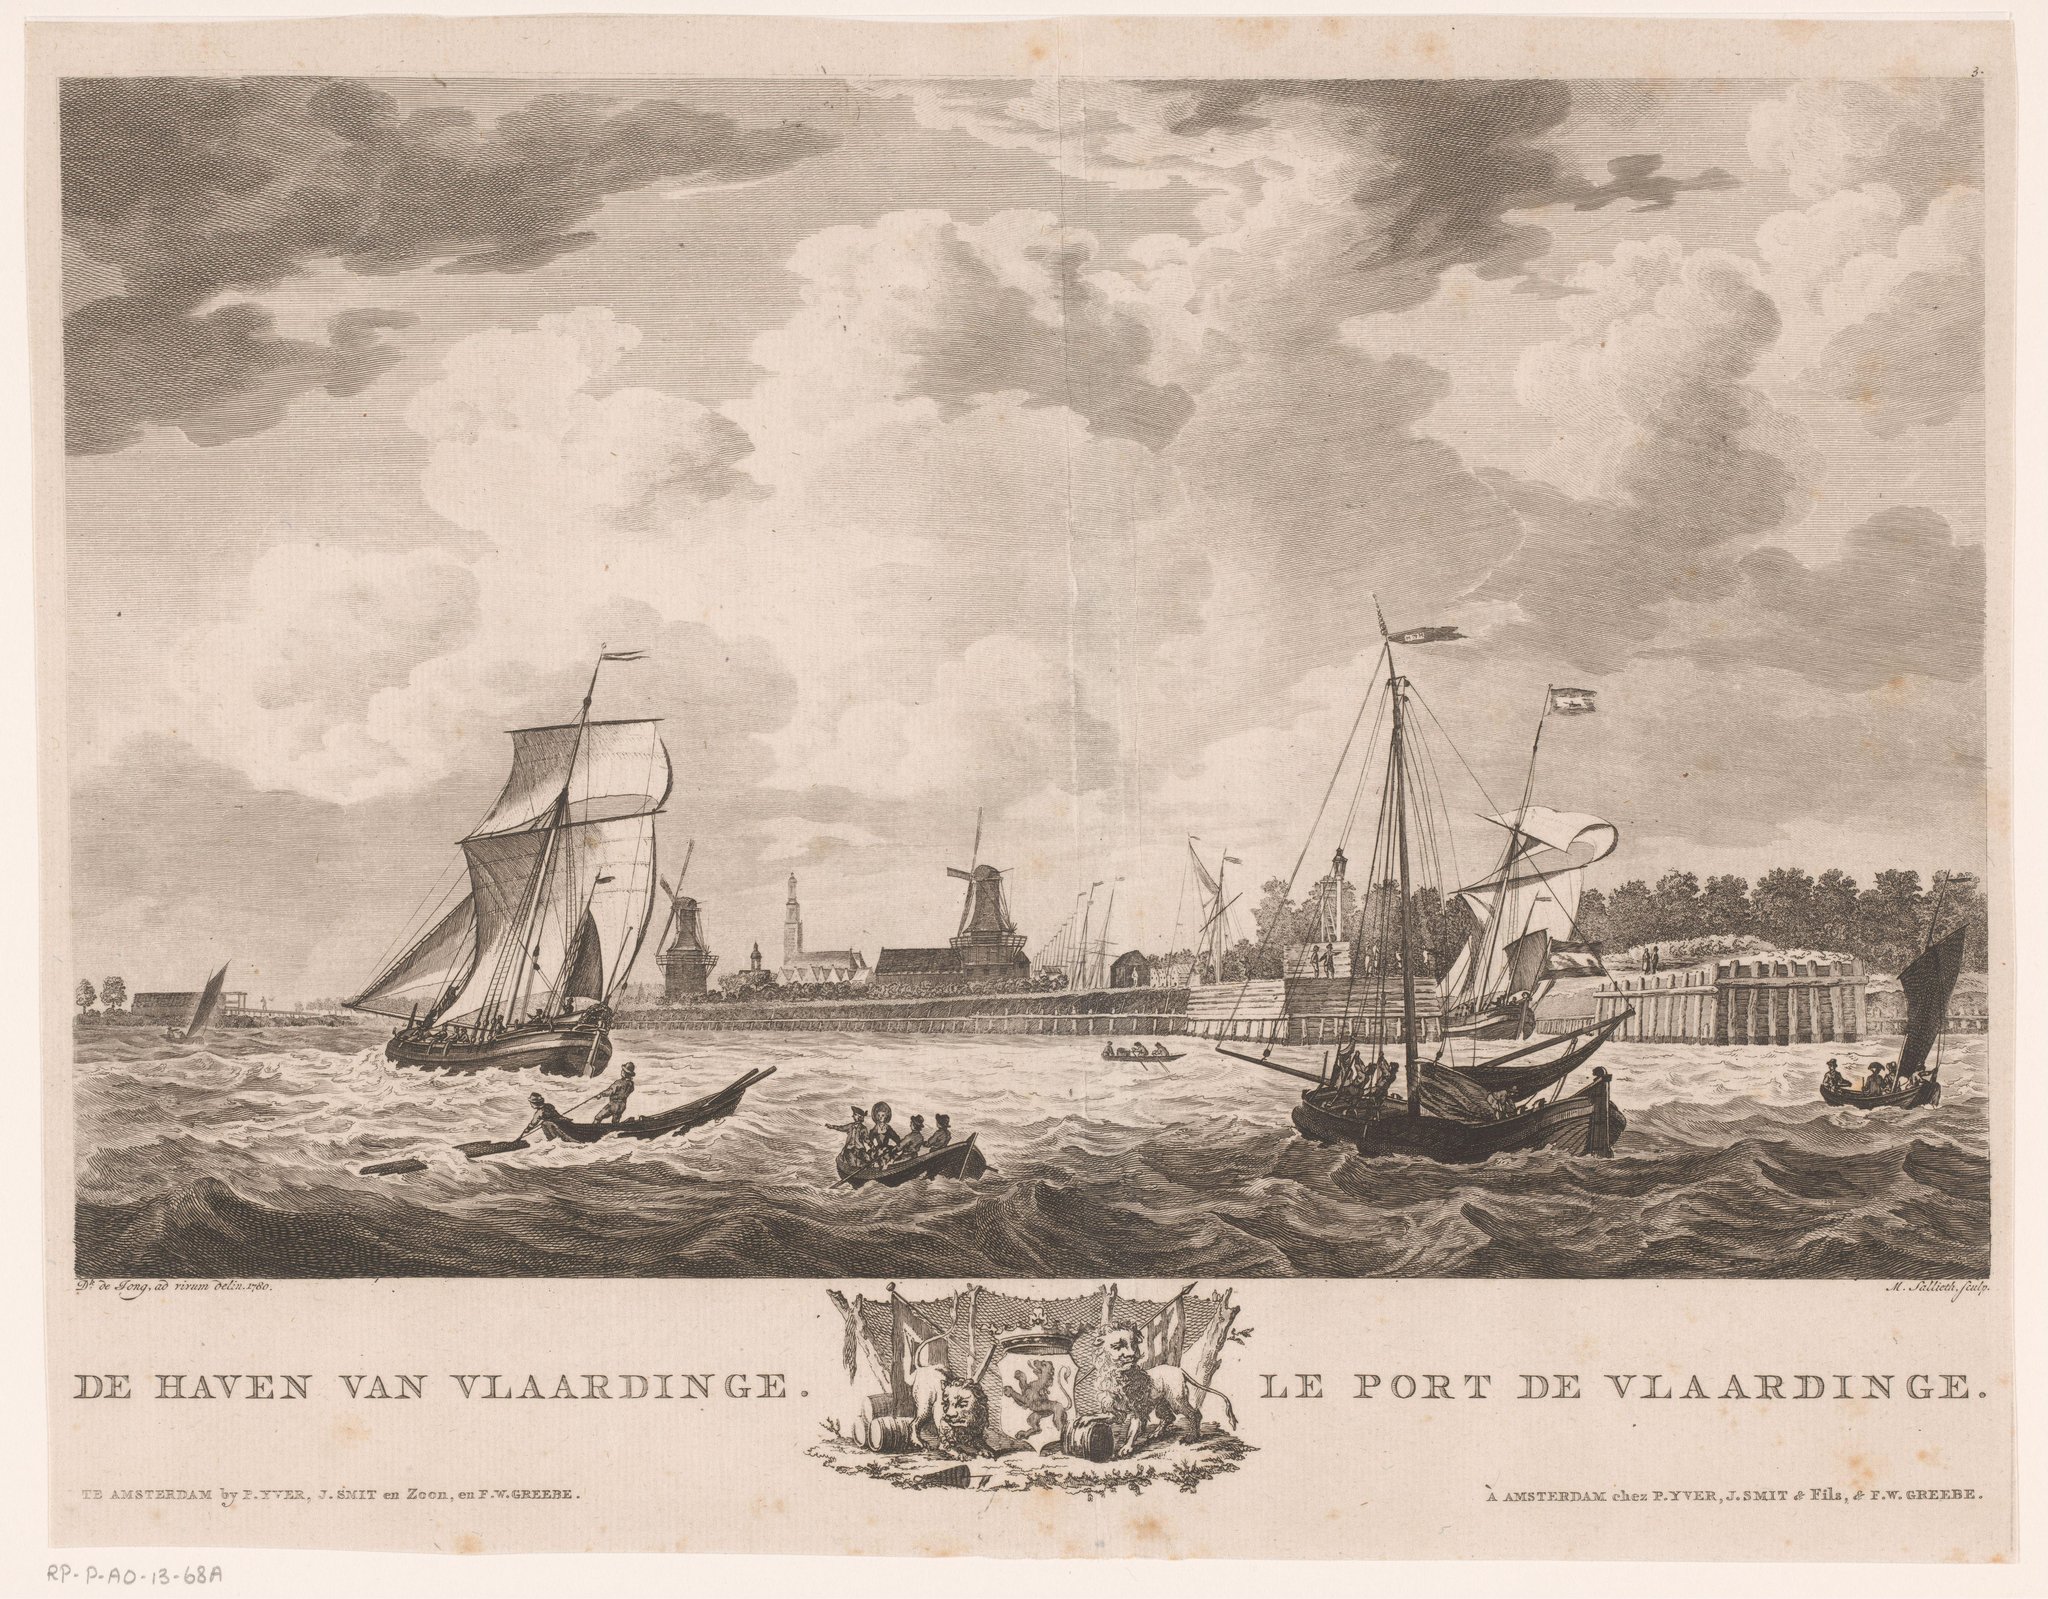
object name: print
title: De haven van Vlaardinge / Le port de Vlaardinge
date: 1780-1787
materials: paper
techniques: etching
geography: amsterdam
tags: harbour, coat of arms (as symbol of the state, etc.) (+ city; municipal), sailing-ship, sailing-boat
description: Latere staat ook gebruikt in: Aa, Cornelis van der. Atlas van de zeehavens der Bataafsche Republiek. Met derzelver beschrijvingen in XXXI kunstplaaten / Atlas van de zeehavens der Bataafsche Republiek, die van Batavia en Onrust. Mitsgaders de afbeeldingen van de haringvisscherij en de walvischvangst (…). Amsterdam: Evert Maaskamp, 1805.